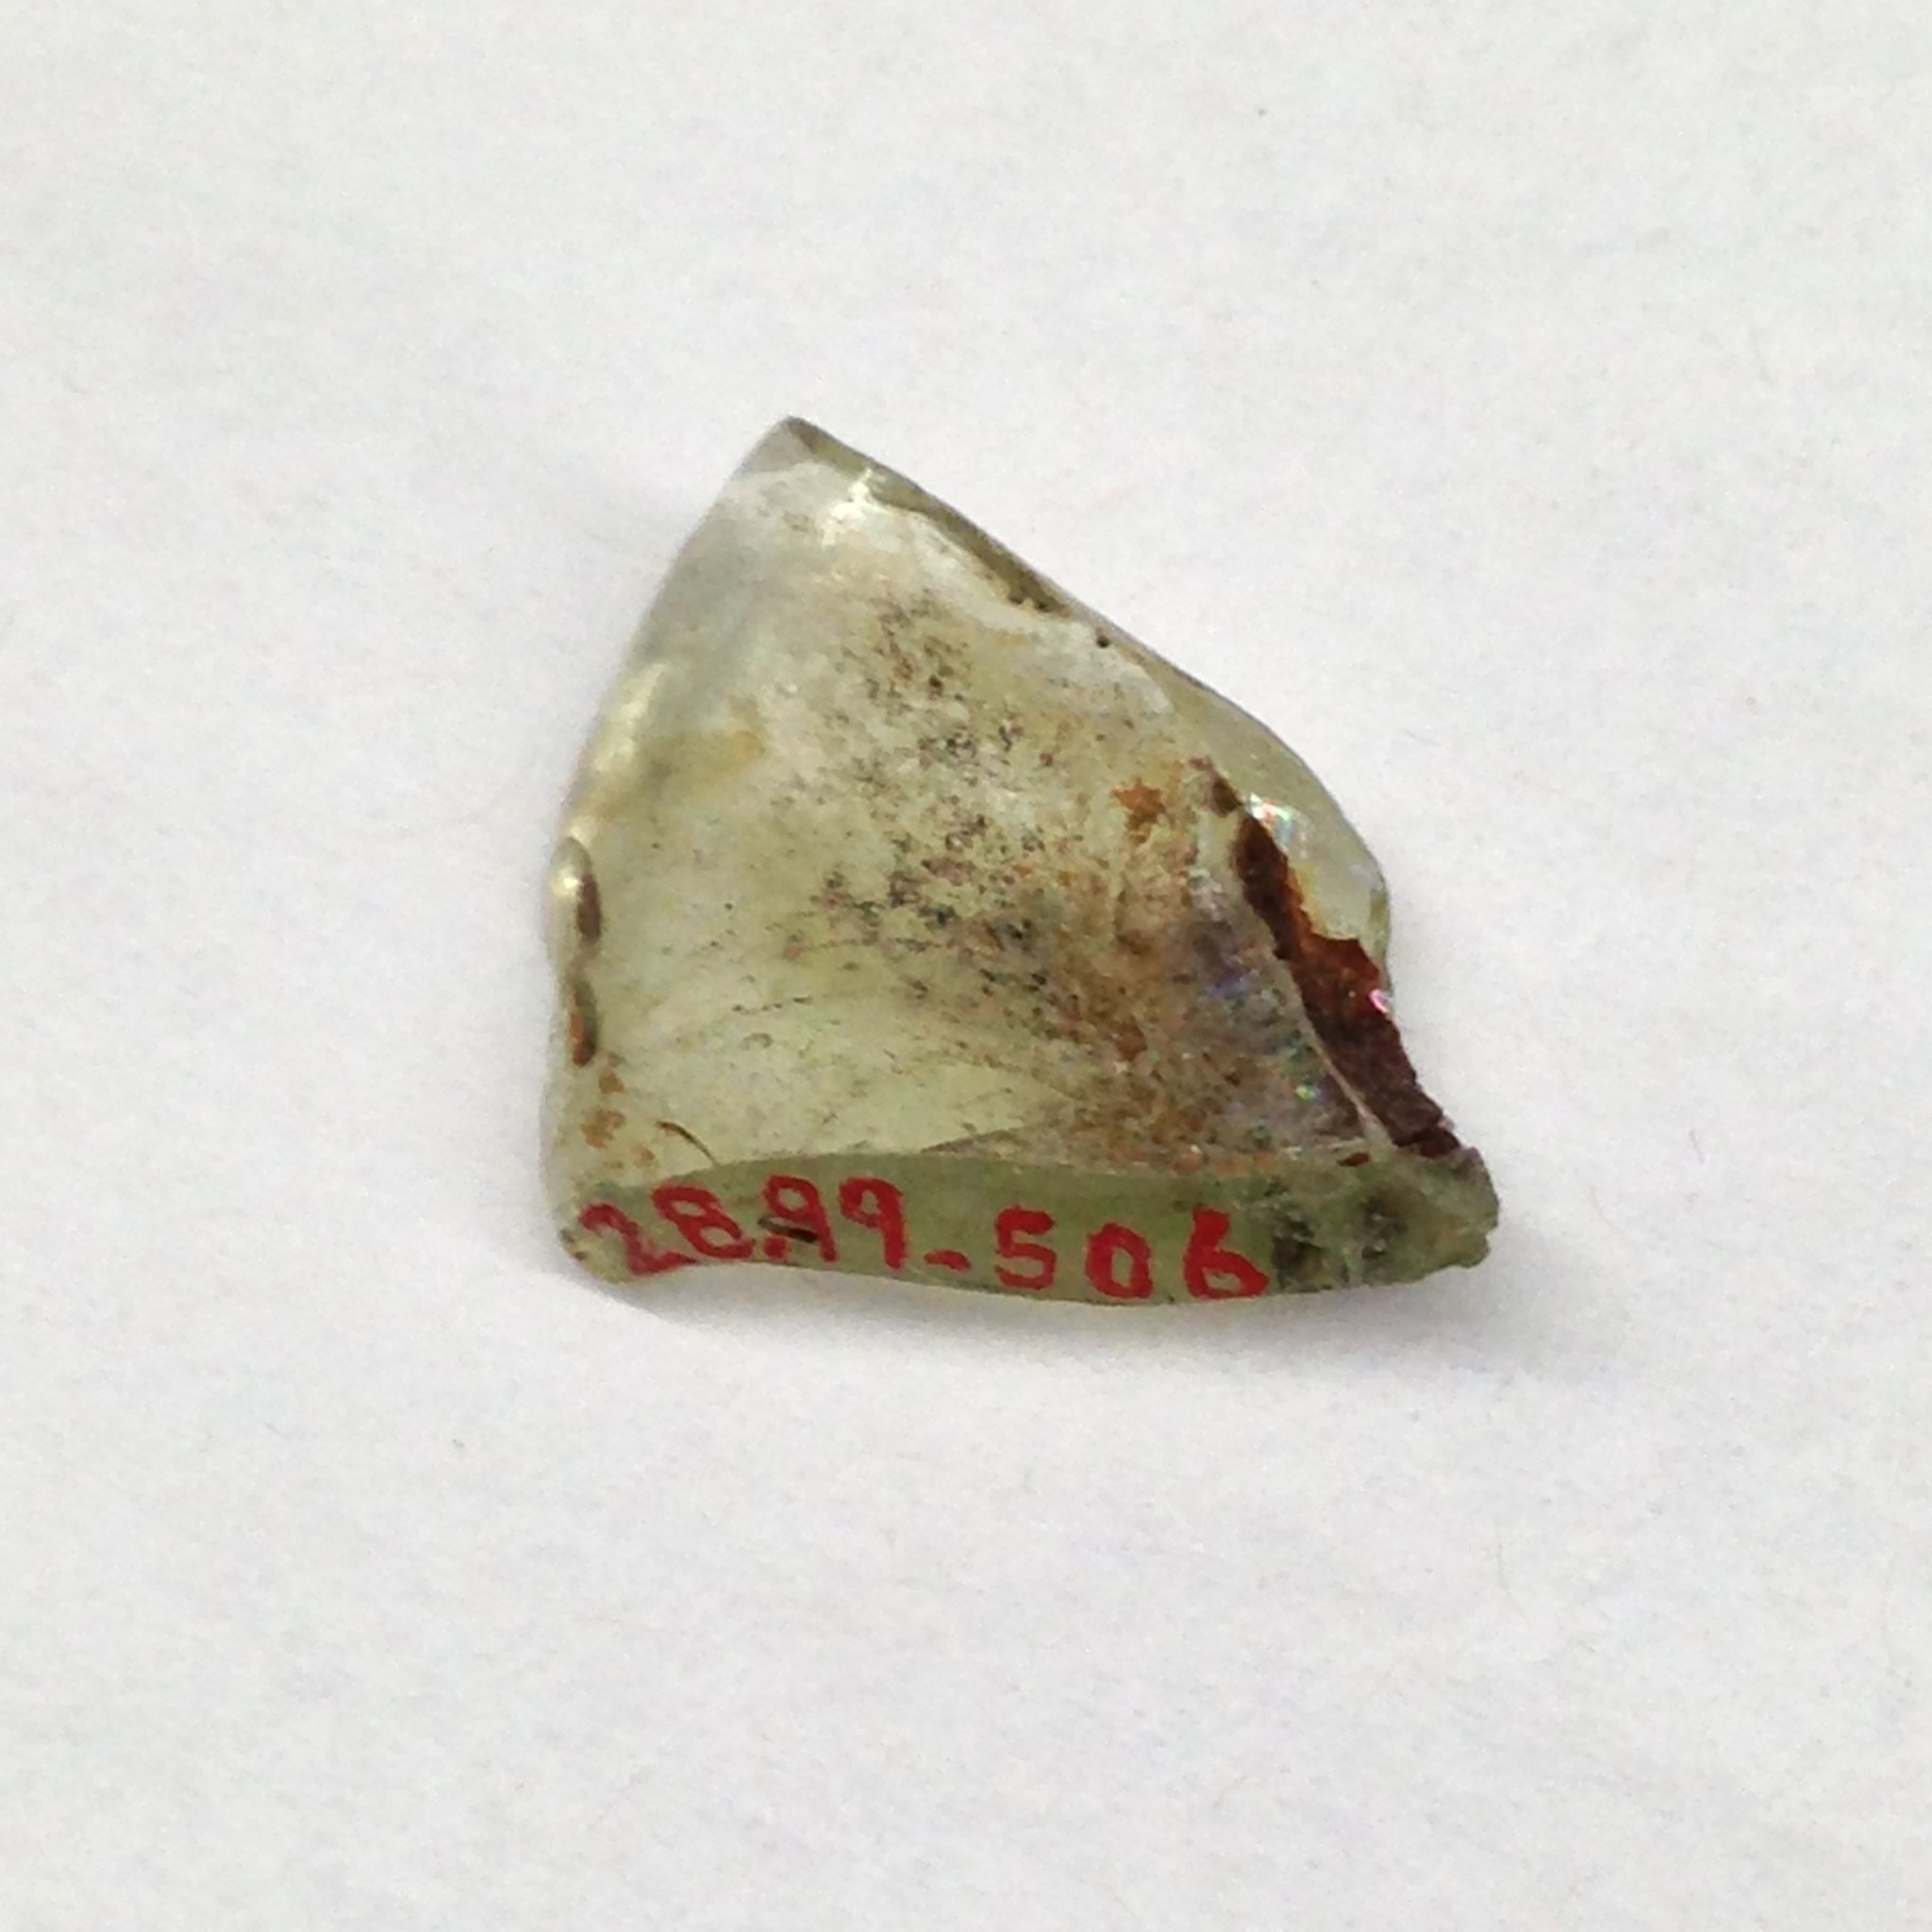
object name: fragment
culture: european or middle eastern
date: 1150-1250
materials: ceramic, glass